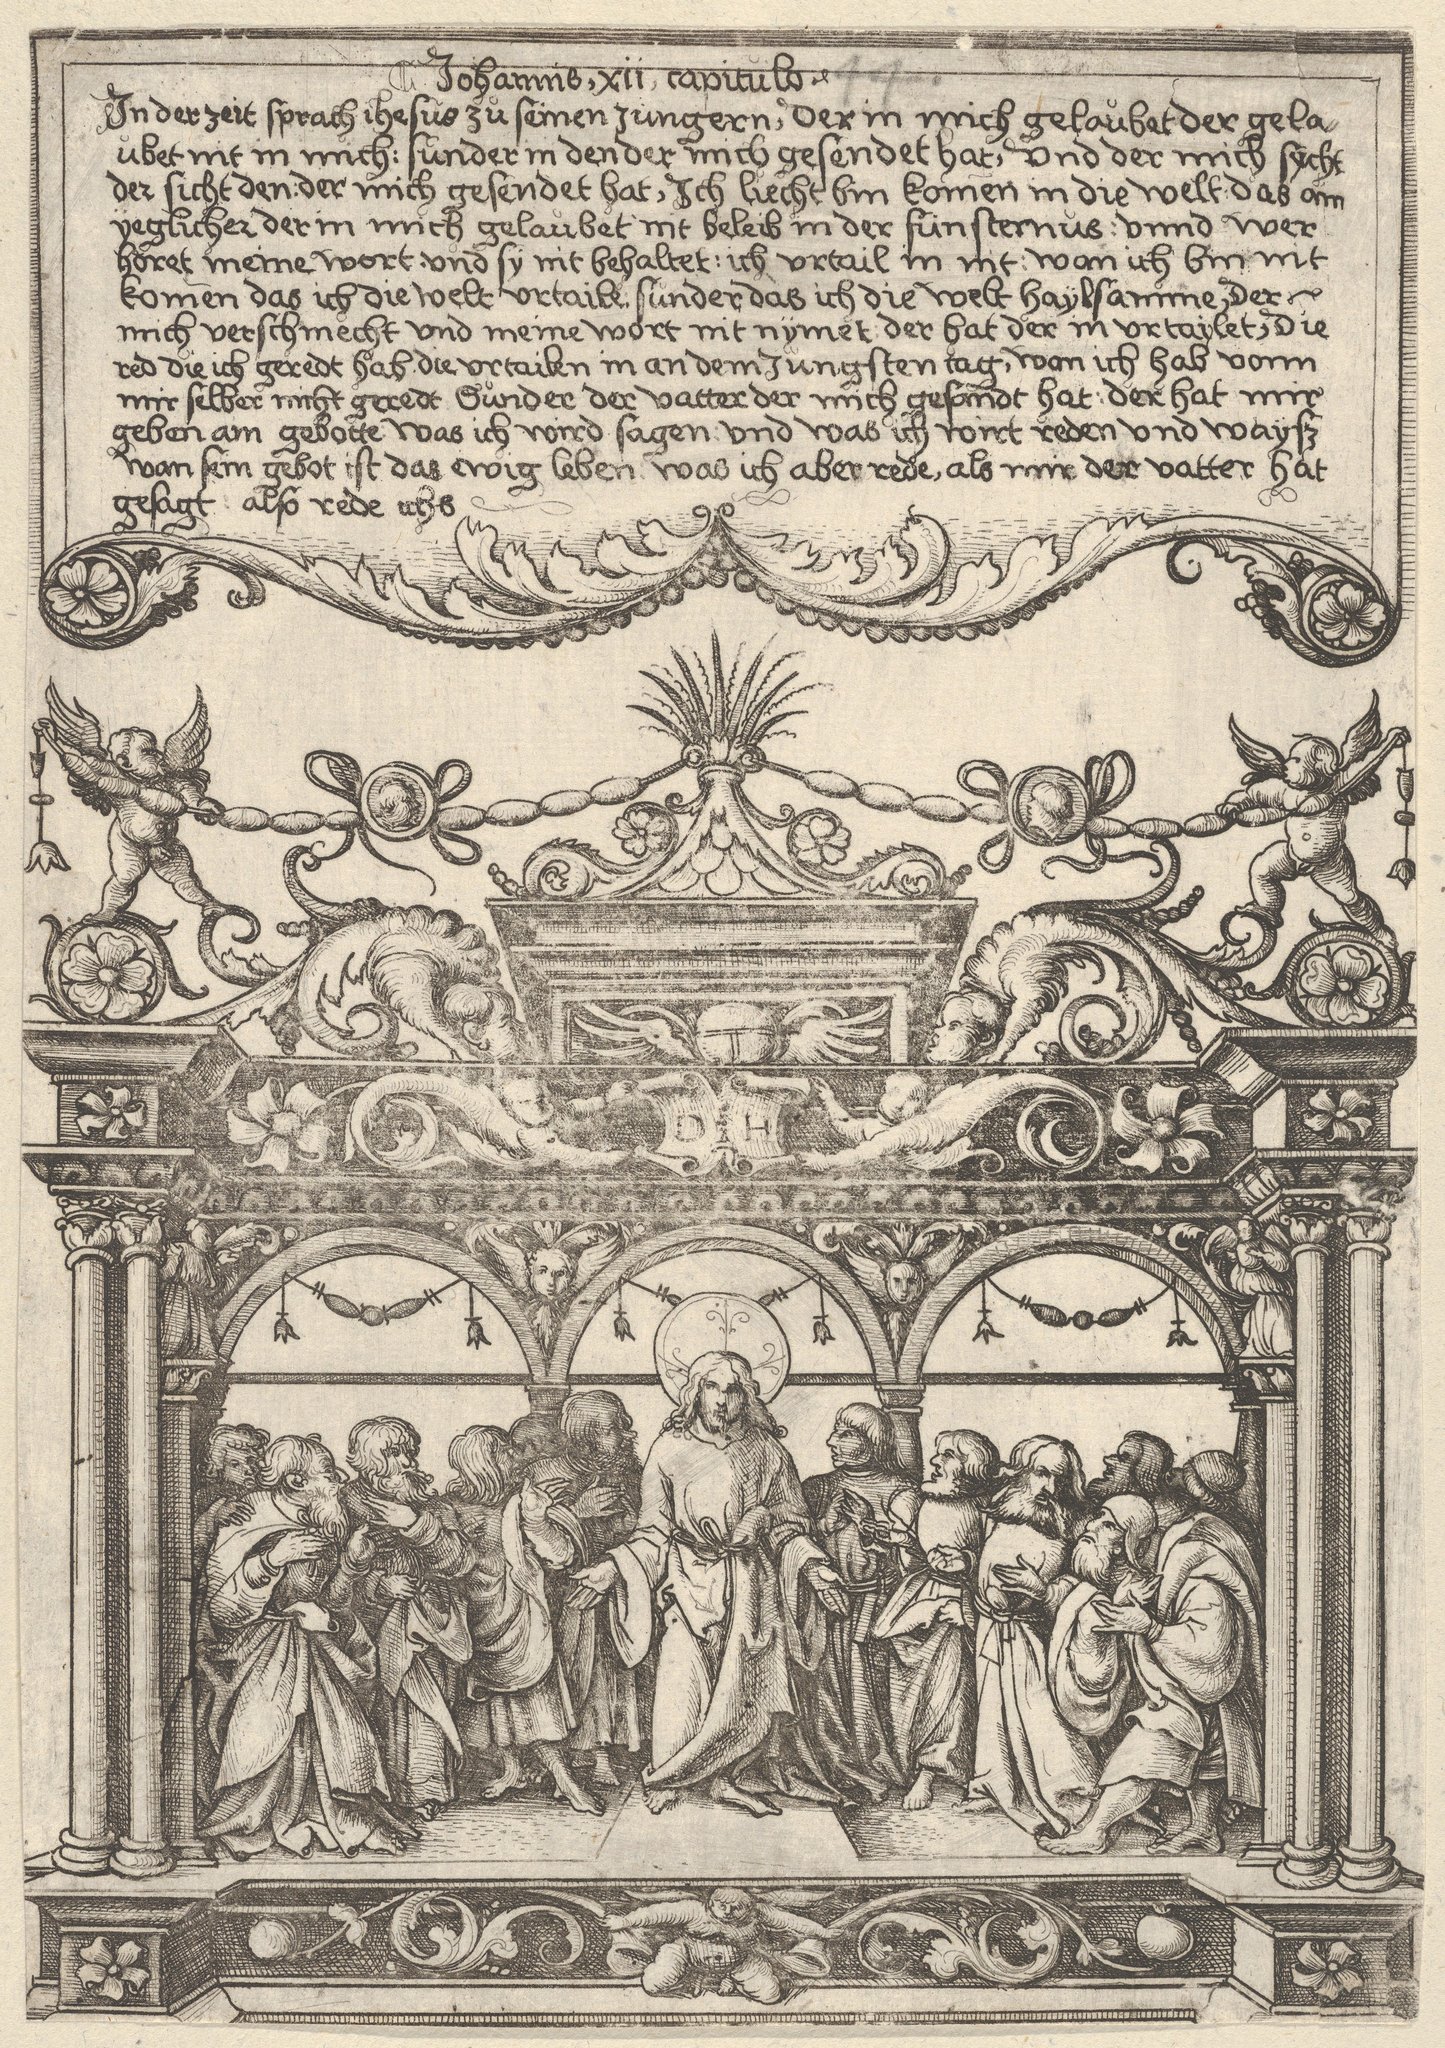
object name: print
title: Christ Testifying his Mission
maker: daniel hopfer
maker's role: artist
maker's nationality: german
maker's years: 1470-1536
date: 1520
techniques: etching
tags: men,christ